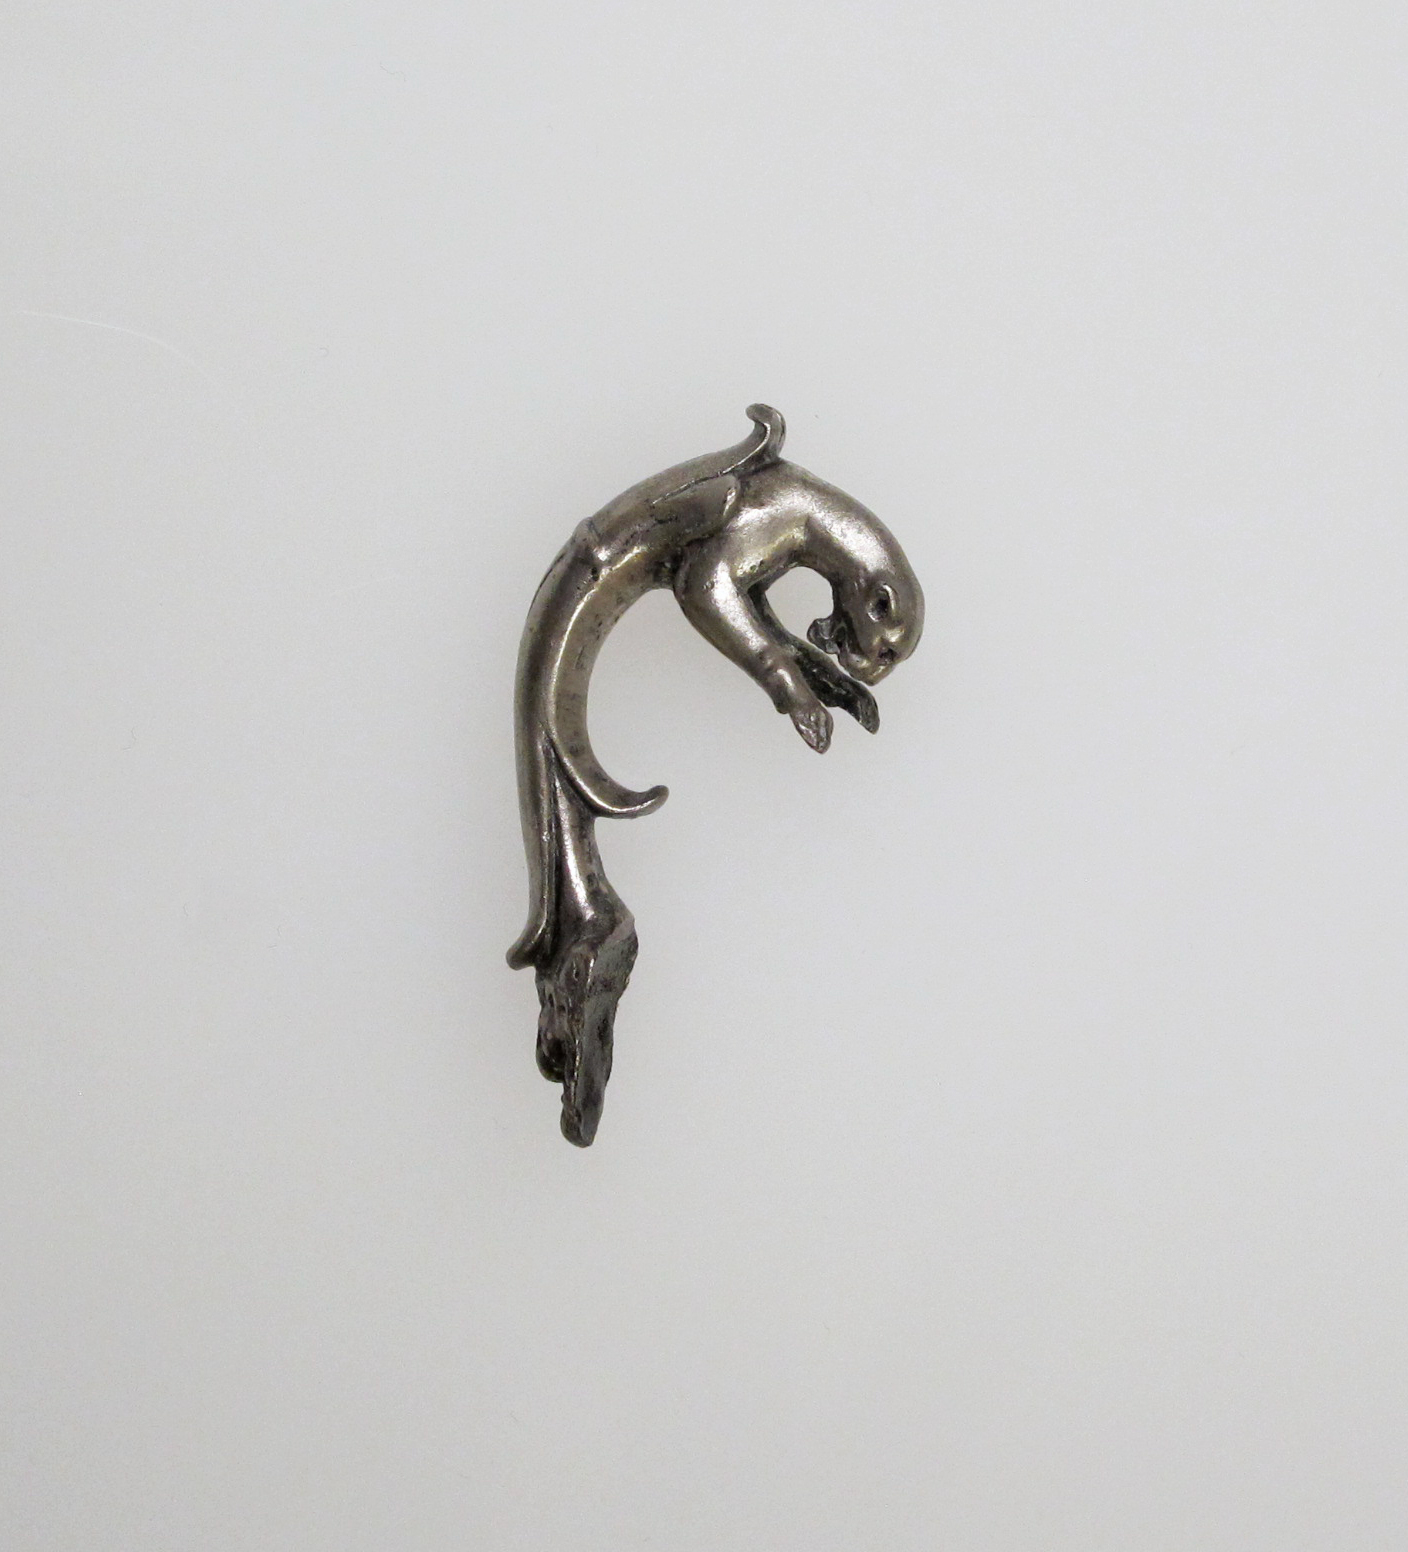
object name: handle of a vase or lamp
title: Silver handle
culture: roman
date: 1-100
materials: silver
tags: lions